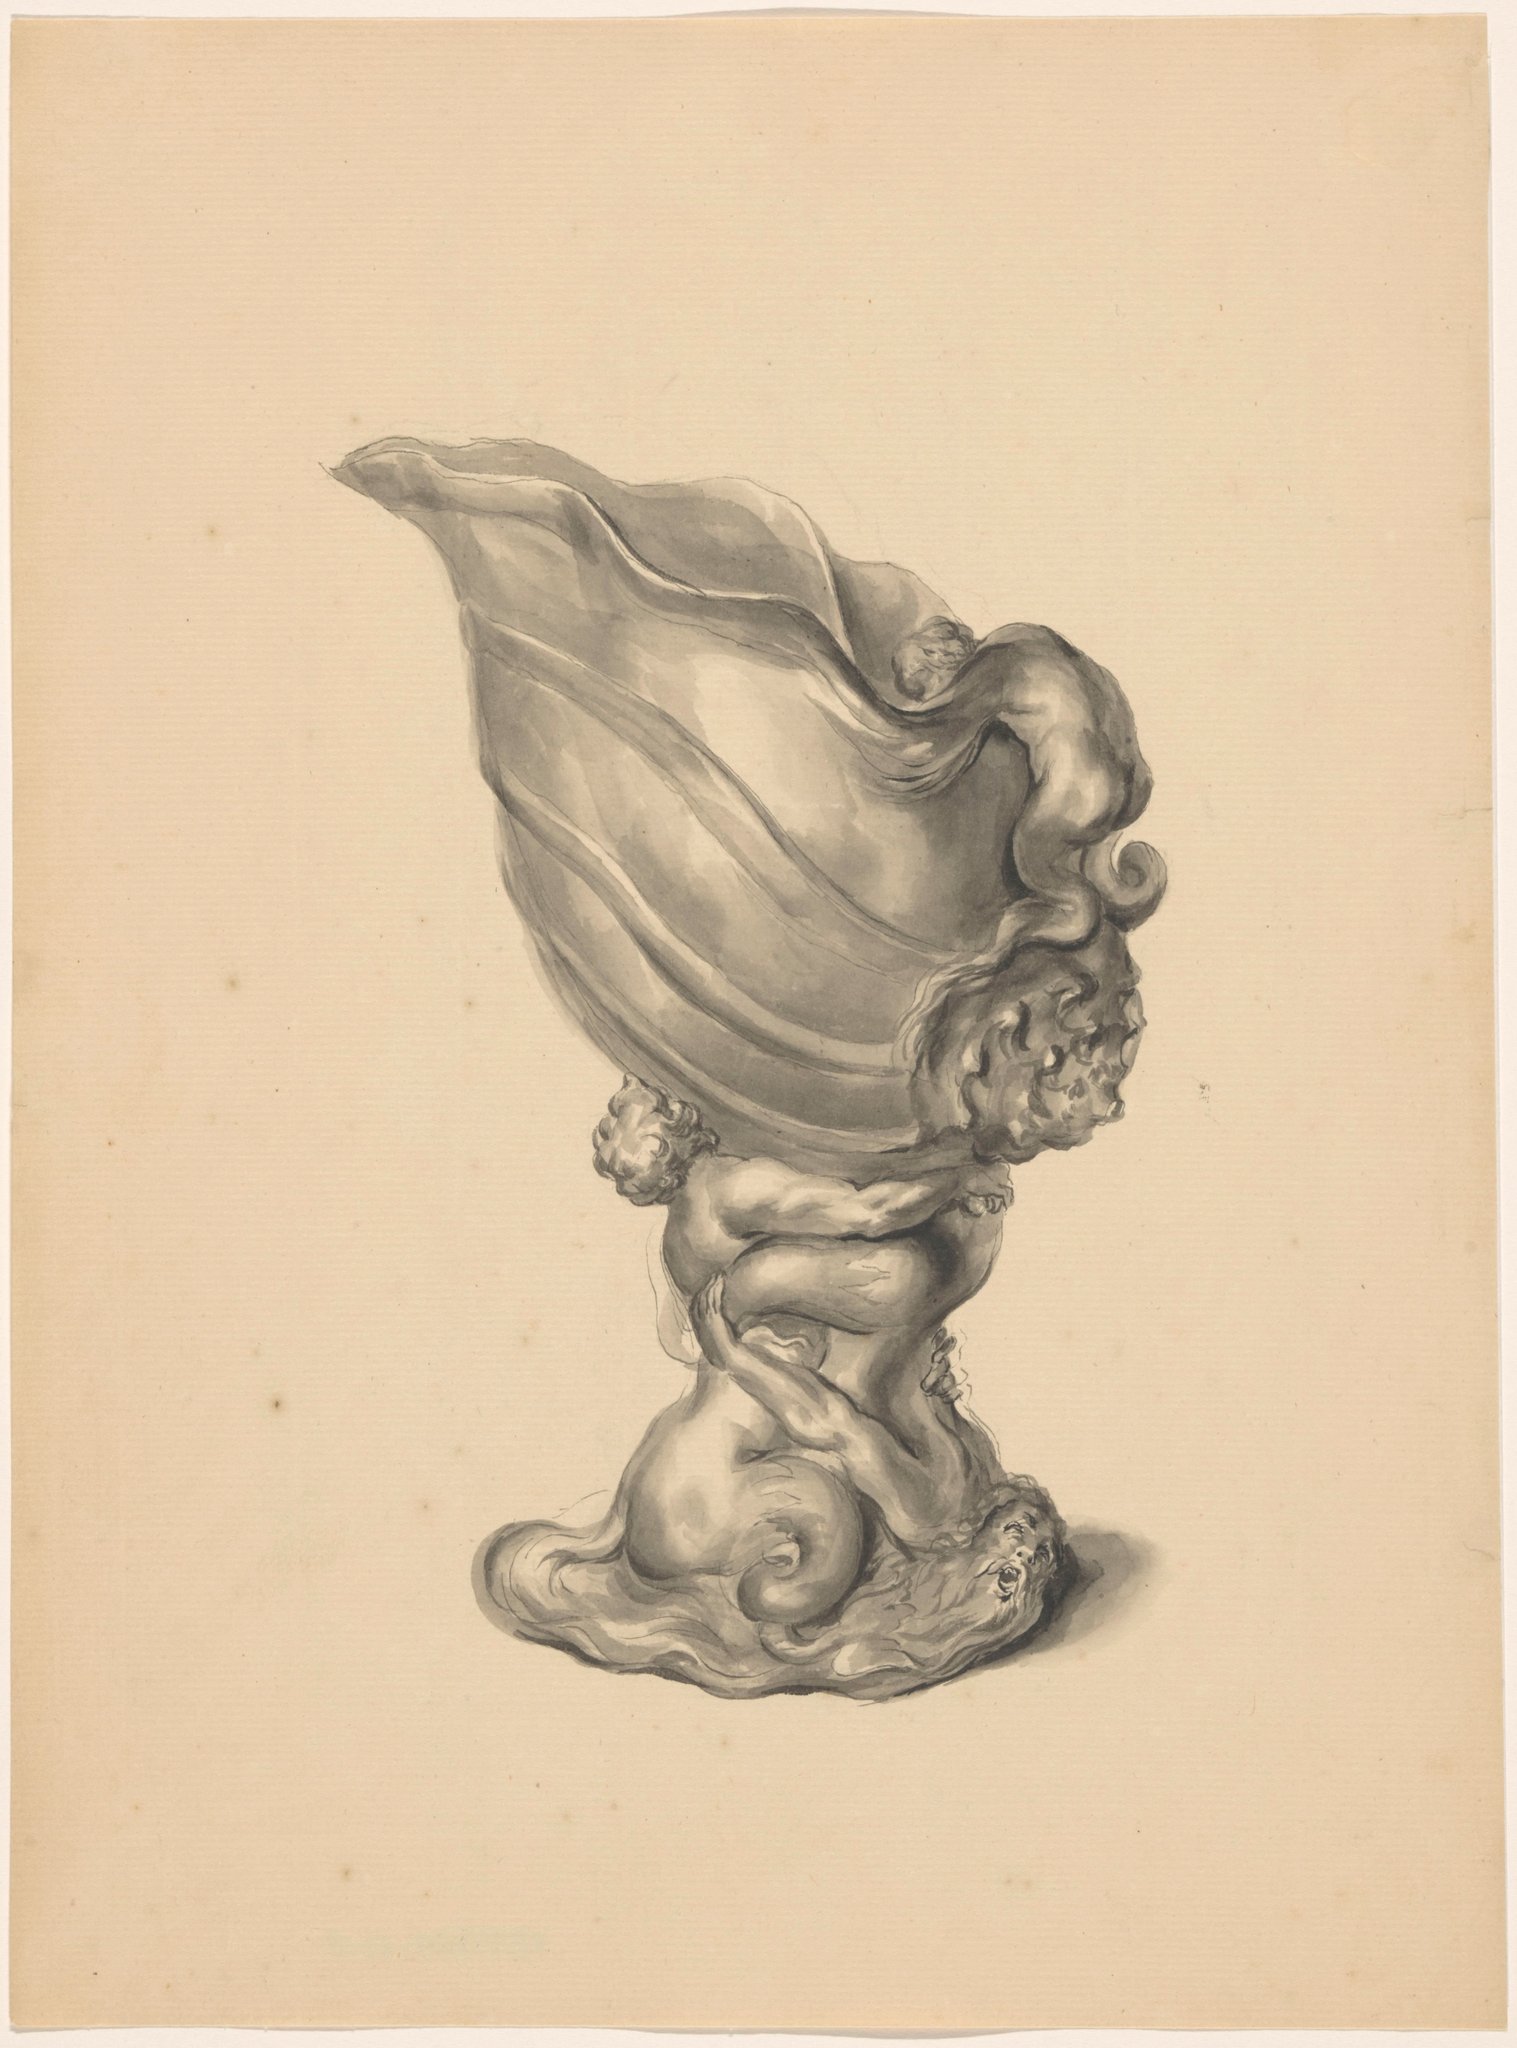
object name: album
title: Tekening van 17e eeuws zilver behorende bij een album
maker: Anonymous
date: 1725-1728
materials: paper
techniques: drawing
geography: amsterdam